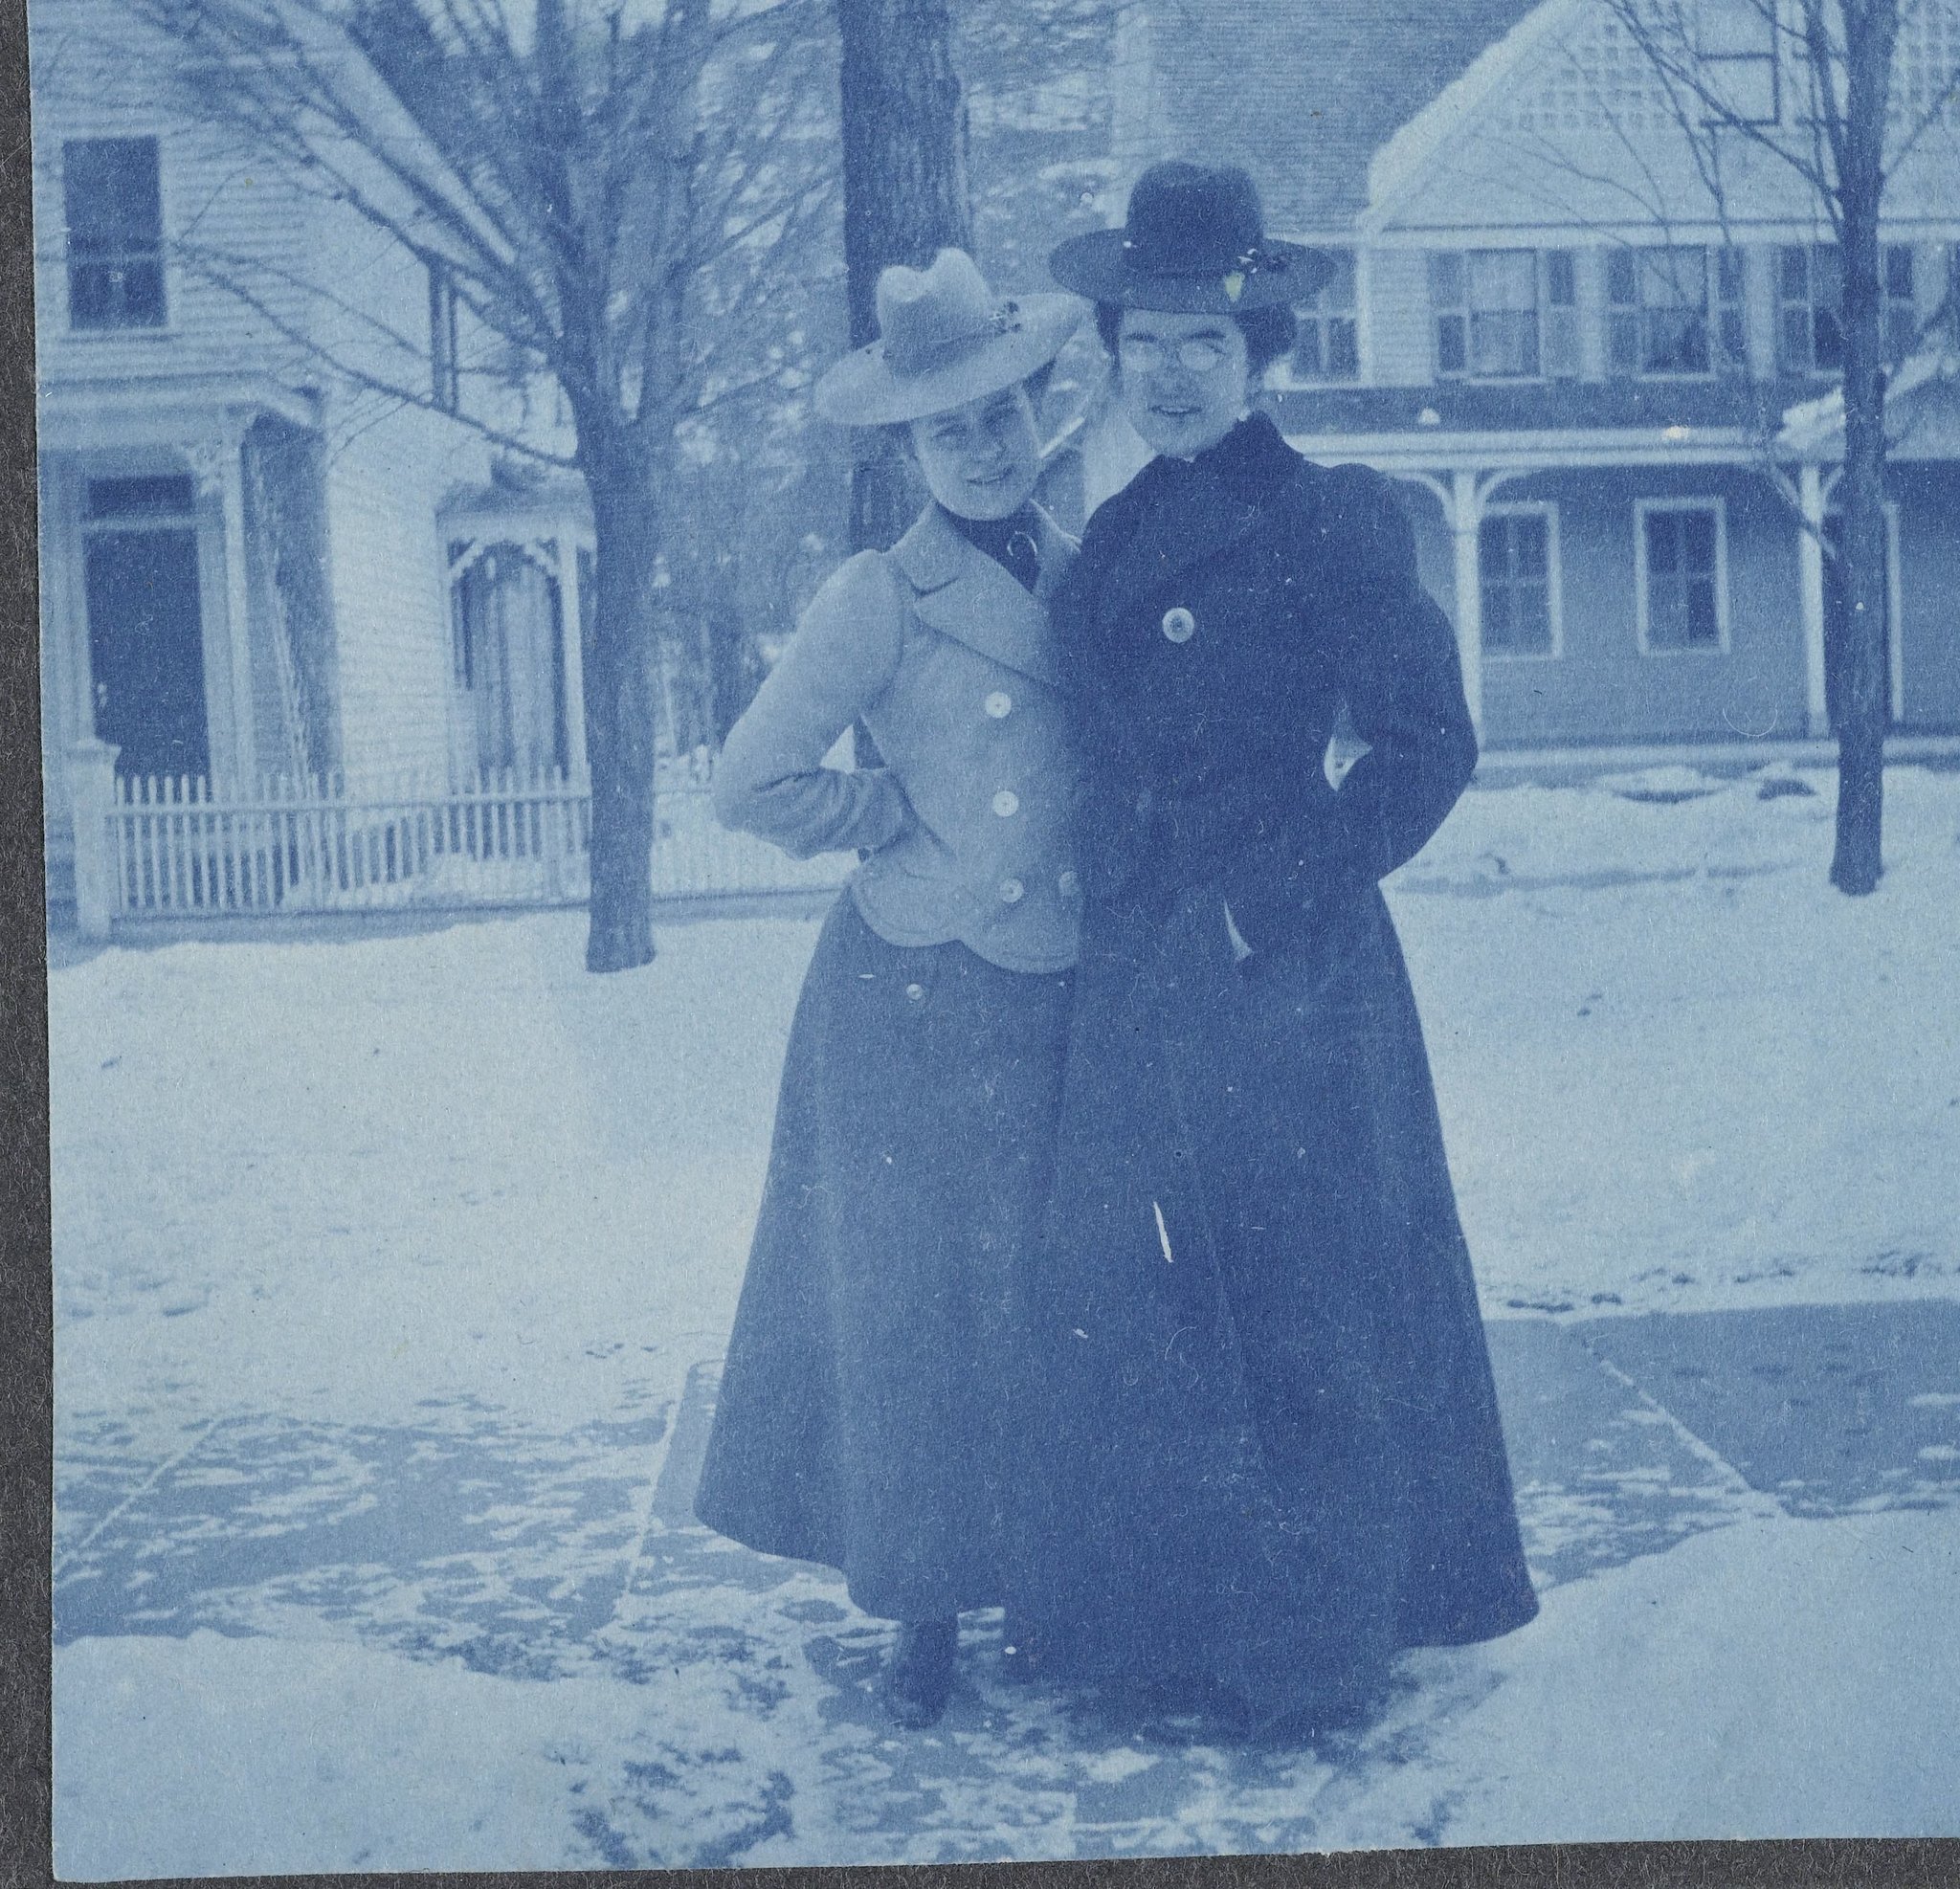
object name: photograph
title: Twee vrouwen op straat (in de sneeuw), Verenigde Staten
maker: Anonymous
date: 1890-1910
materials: paper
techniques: cyanotype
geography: michigan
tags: snow